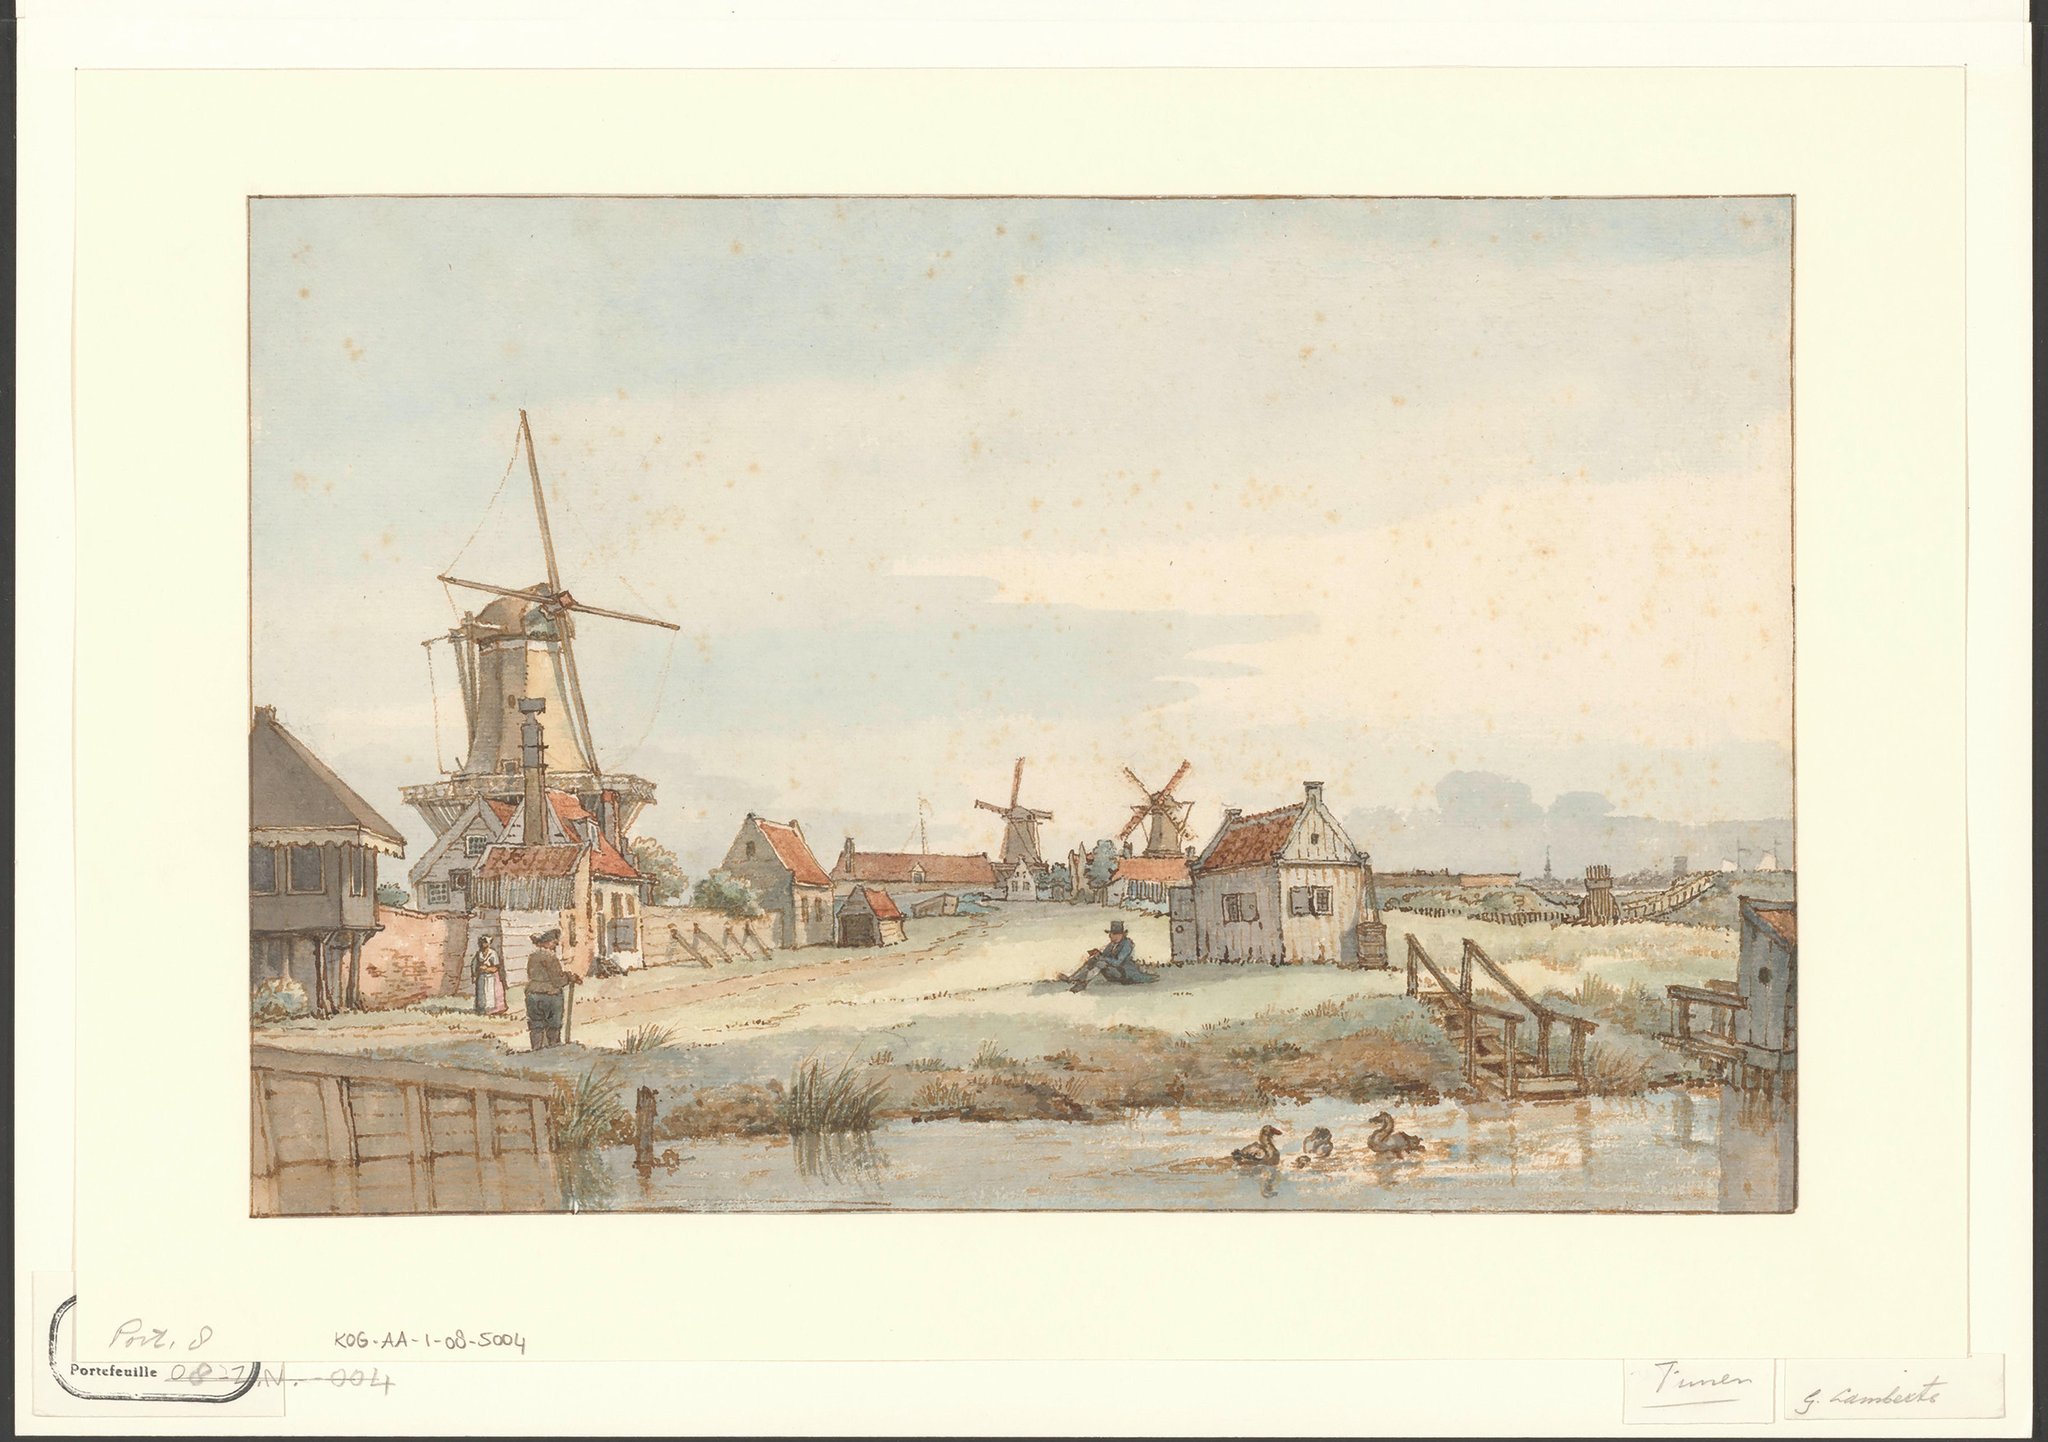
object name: drawing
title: Gezicht op de militaire strafplaats aan het Funen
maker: gerrit lamberts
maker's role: bookseller, draughtsman, print maker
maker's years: 1776-1850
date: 1816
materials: ink, paper, pencil, watercolor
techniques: brush, pen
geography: amsterdam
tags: city-view in general; 'veduta', road, path, windmill in landscape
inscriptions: inscription: ‘Port. 8’, collector's mark: ‘8’ Lugt 1641b, inscription: ‘en kom en (...) ons Scheep begeren’, inscription: ‘Funen / G. Lamberts’, signature, date and inscription: ‘Gezicht van den (...) G. Lamberts. 1816.’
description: Onderwerpsrubriek binnen de Atlas Amsterdam: Egelantiersdwarsstraat, Egelantiersgracht, Elandsgracht, Engelschesteeg, Foeliedwarsstraat, Frederiksplein, Funen.